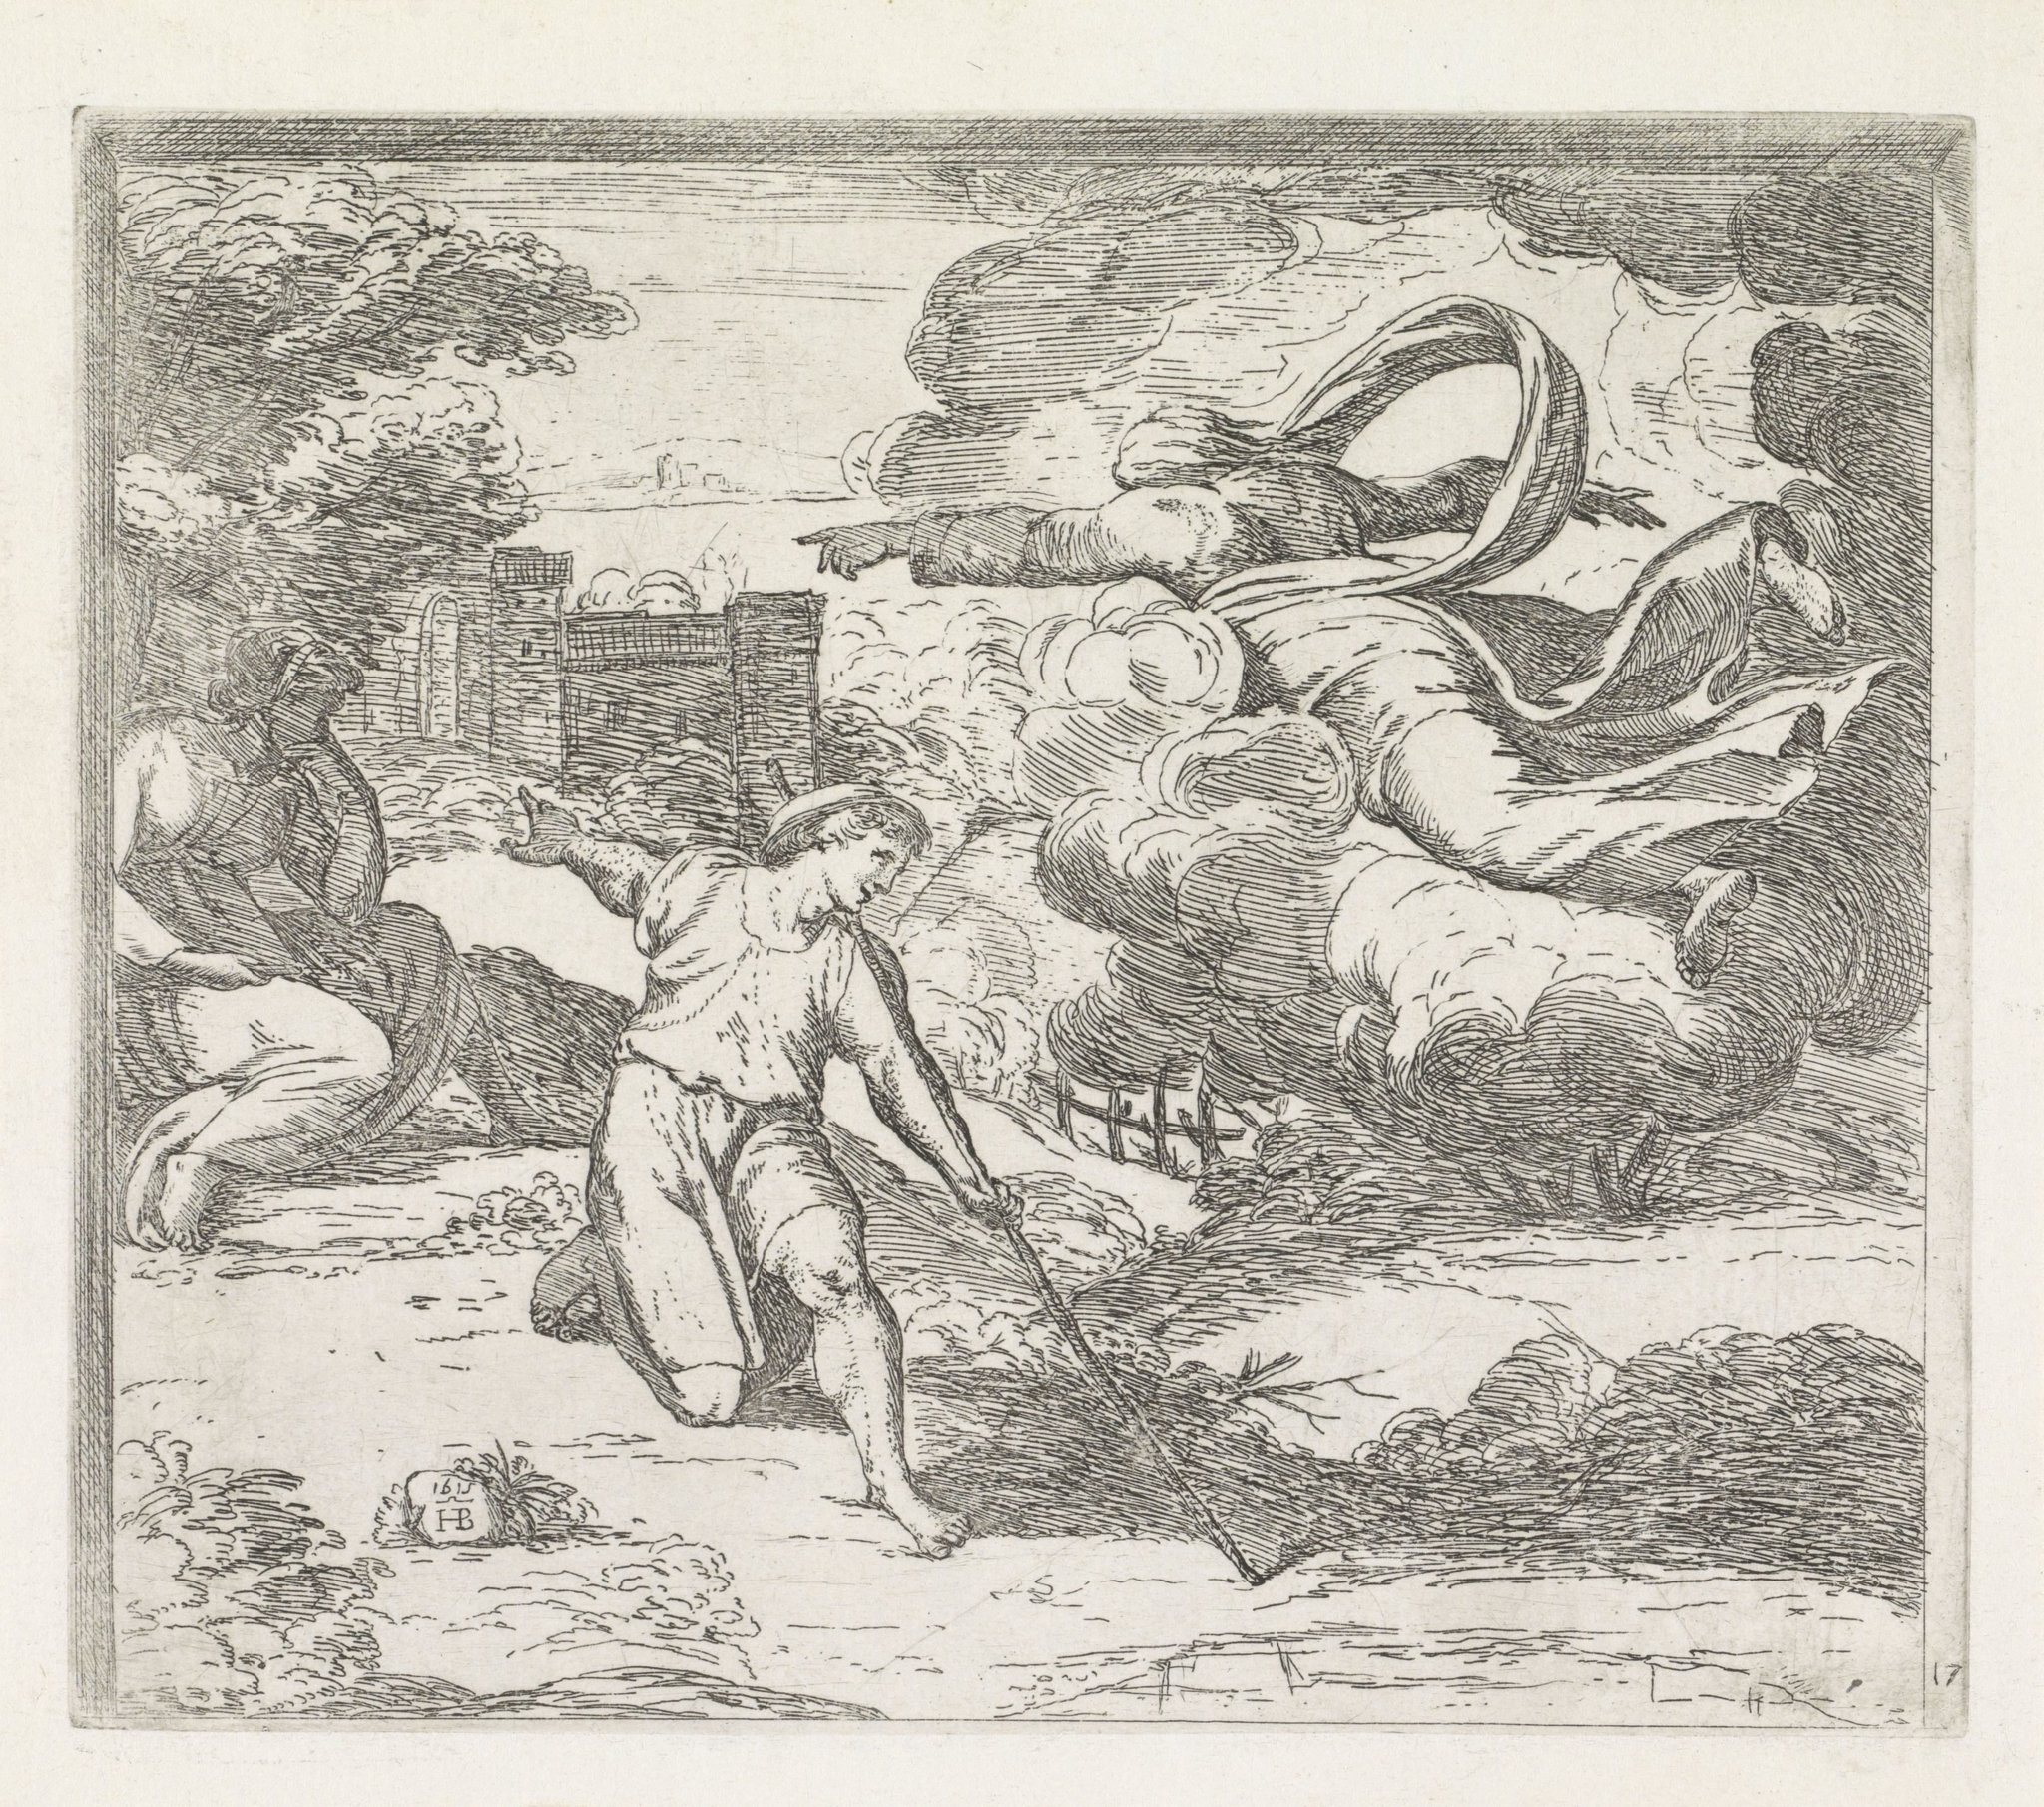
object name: print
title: God waarschuwt Isaak niet naar Egypte te gaan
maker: orazio borgianni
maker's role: print maker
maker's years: 1578-1616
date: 1615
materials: paper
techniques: etching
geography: vatican city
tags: god appears to isaac and warns him not to journey into egypt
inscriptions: collector's mark: Lugt 2165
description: Isaak zit op een knie in een landschap. Voor hem verschijnt God die hem waarschuwt om niet naar Egypte te gaan. Links een vrouw onder een boom.